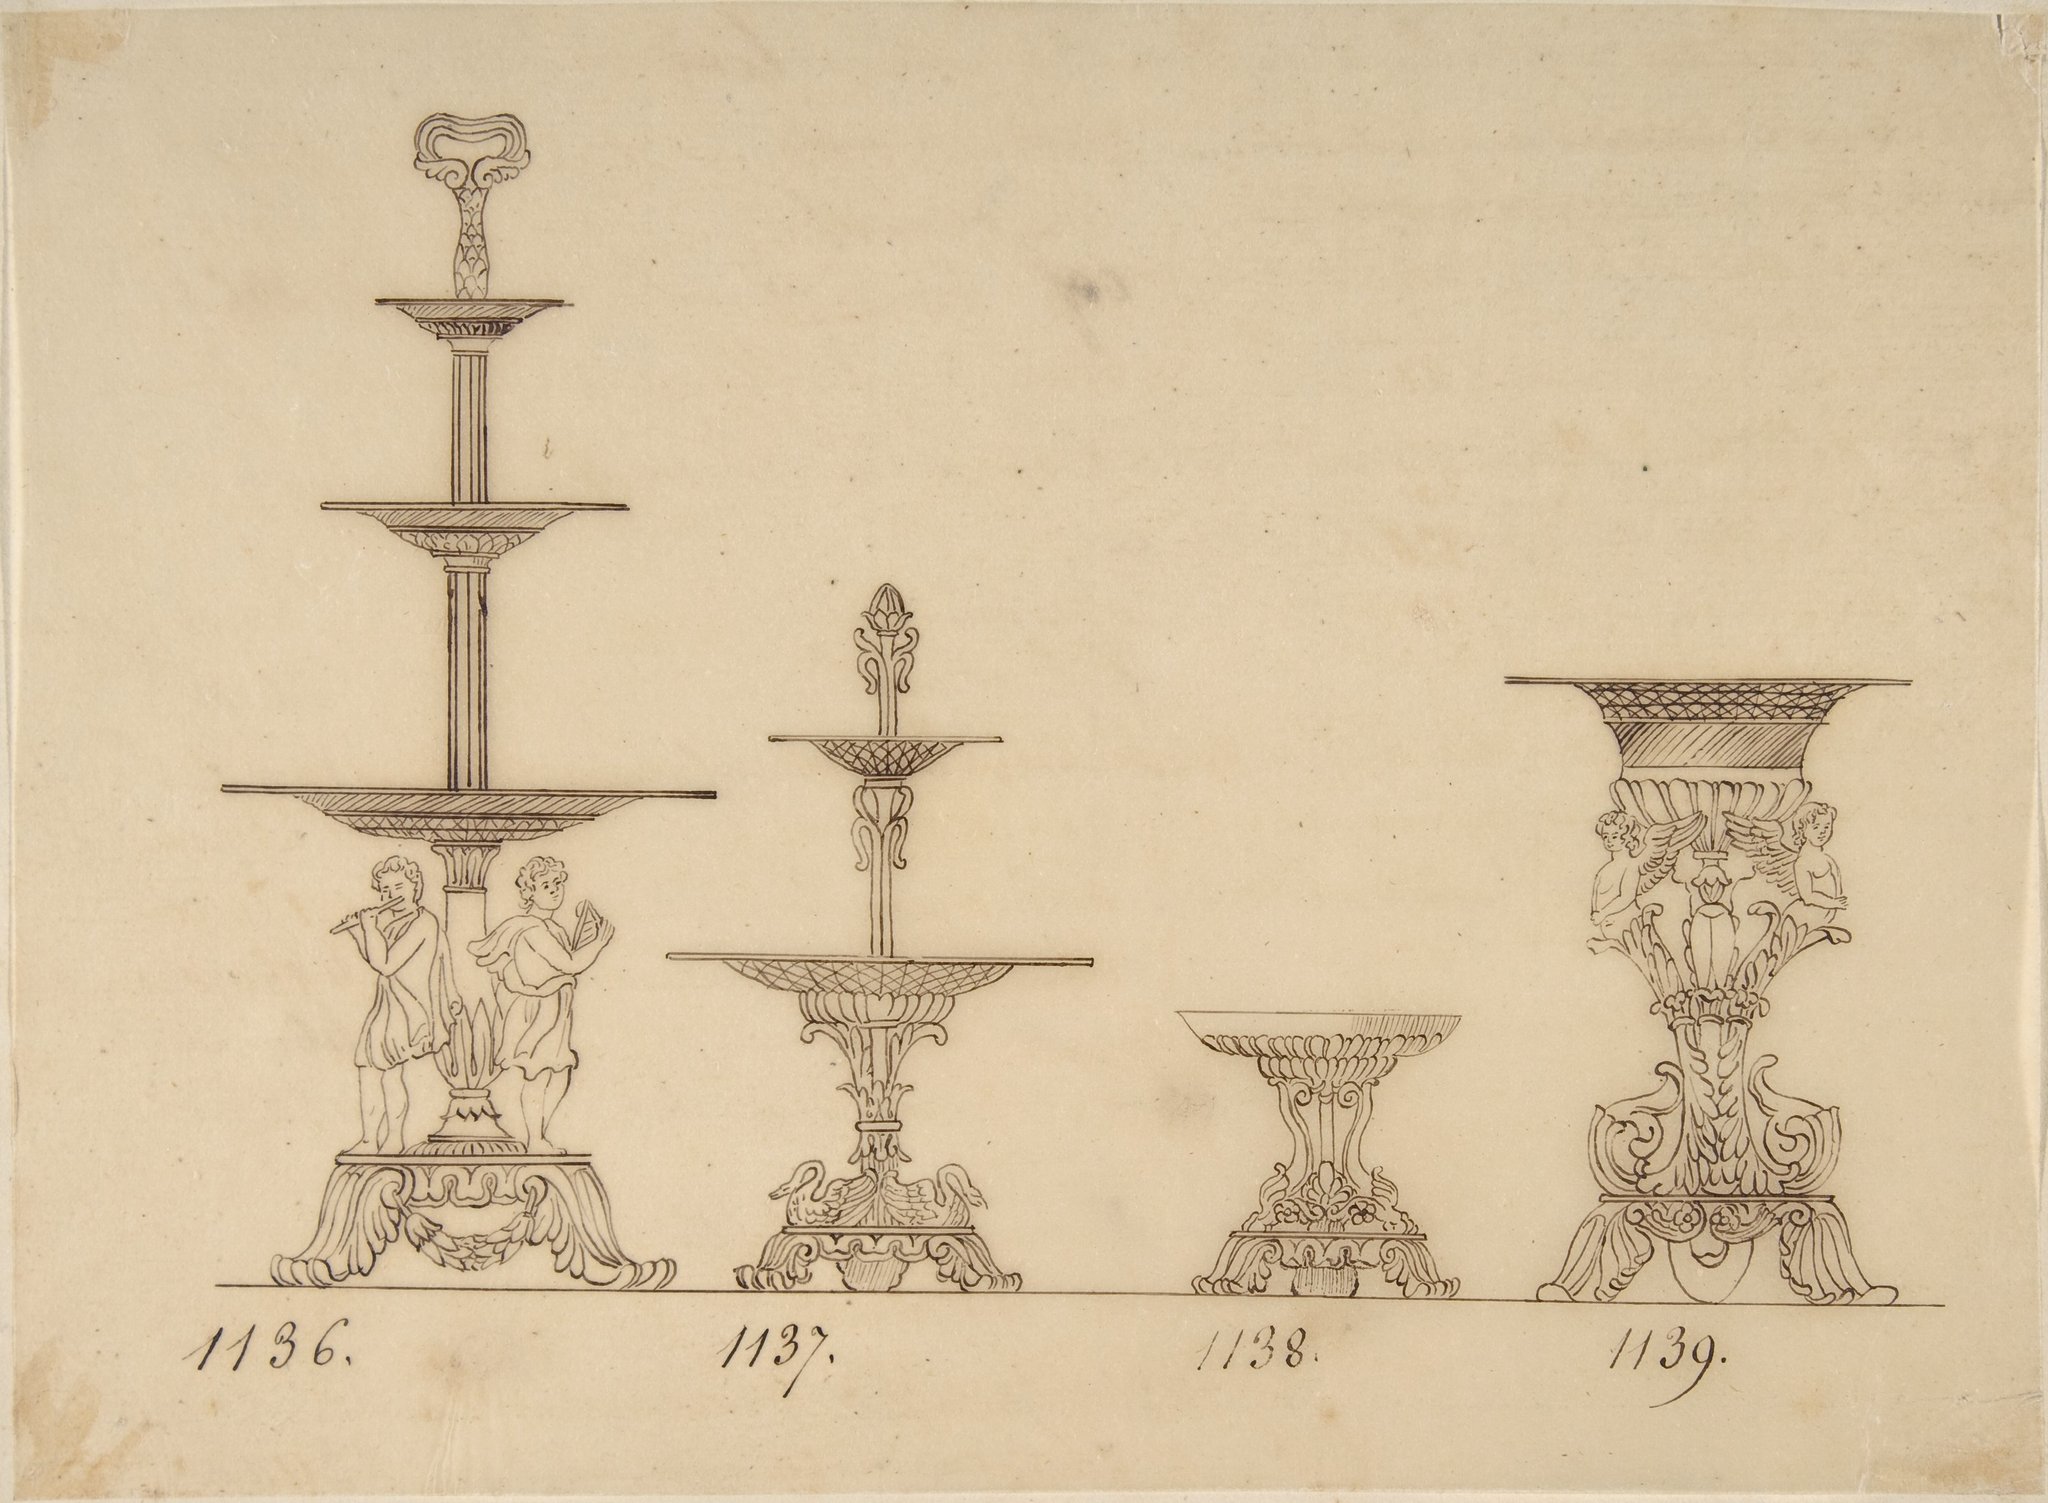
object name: drawing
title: Designs for Serving Trays, a Dish and an Urn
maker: anonymous, french, 19th century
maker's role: artist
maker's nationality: french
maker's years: 1800-1900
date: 1801-1900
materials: ink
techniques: pen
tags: dishes,trays,urns